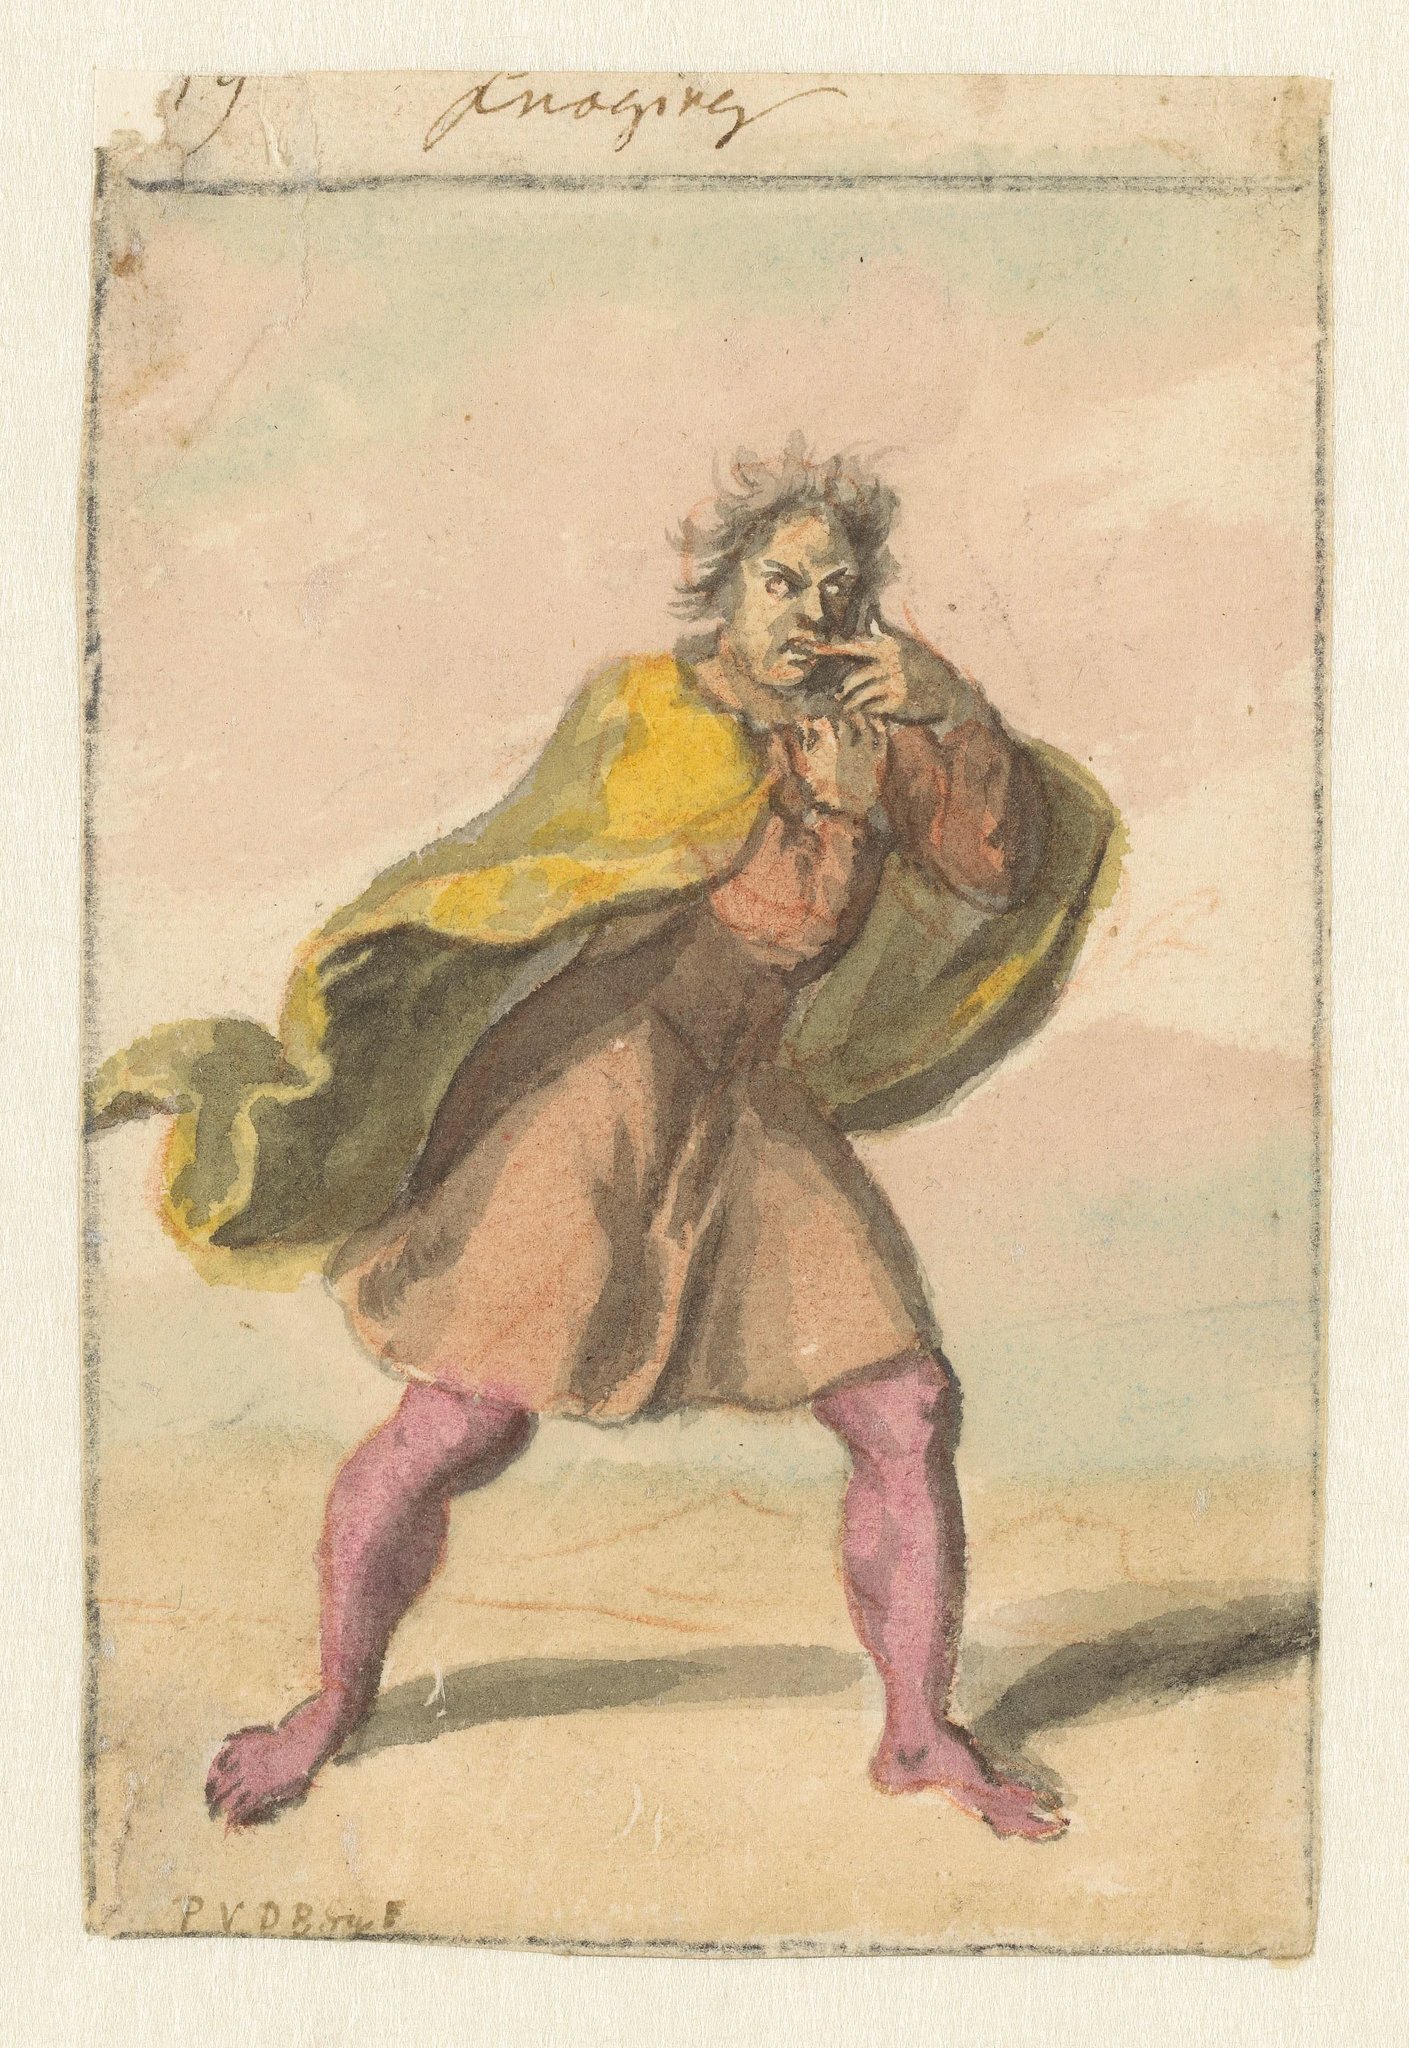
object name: drawing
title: Uitbeeldingen van karakters, eigenschappen, deugden en ondeugden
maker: pieter van den berge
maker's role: draughtsman, print maker, printer, publisher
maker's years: 1659-1737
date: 1675-1737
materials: chalk, paper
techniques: brush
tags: envy; 'invidia' (ripa) ~ personification of one of the seven deadly sins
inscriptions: number: ‘19 (?)’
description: Een man enigszins naar rechts gewend, gaat naar die zijde. Hij bijt op de wijsvinger van zijn hand.